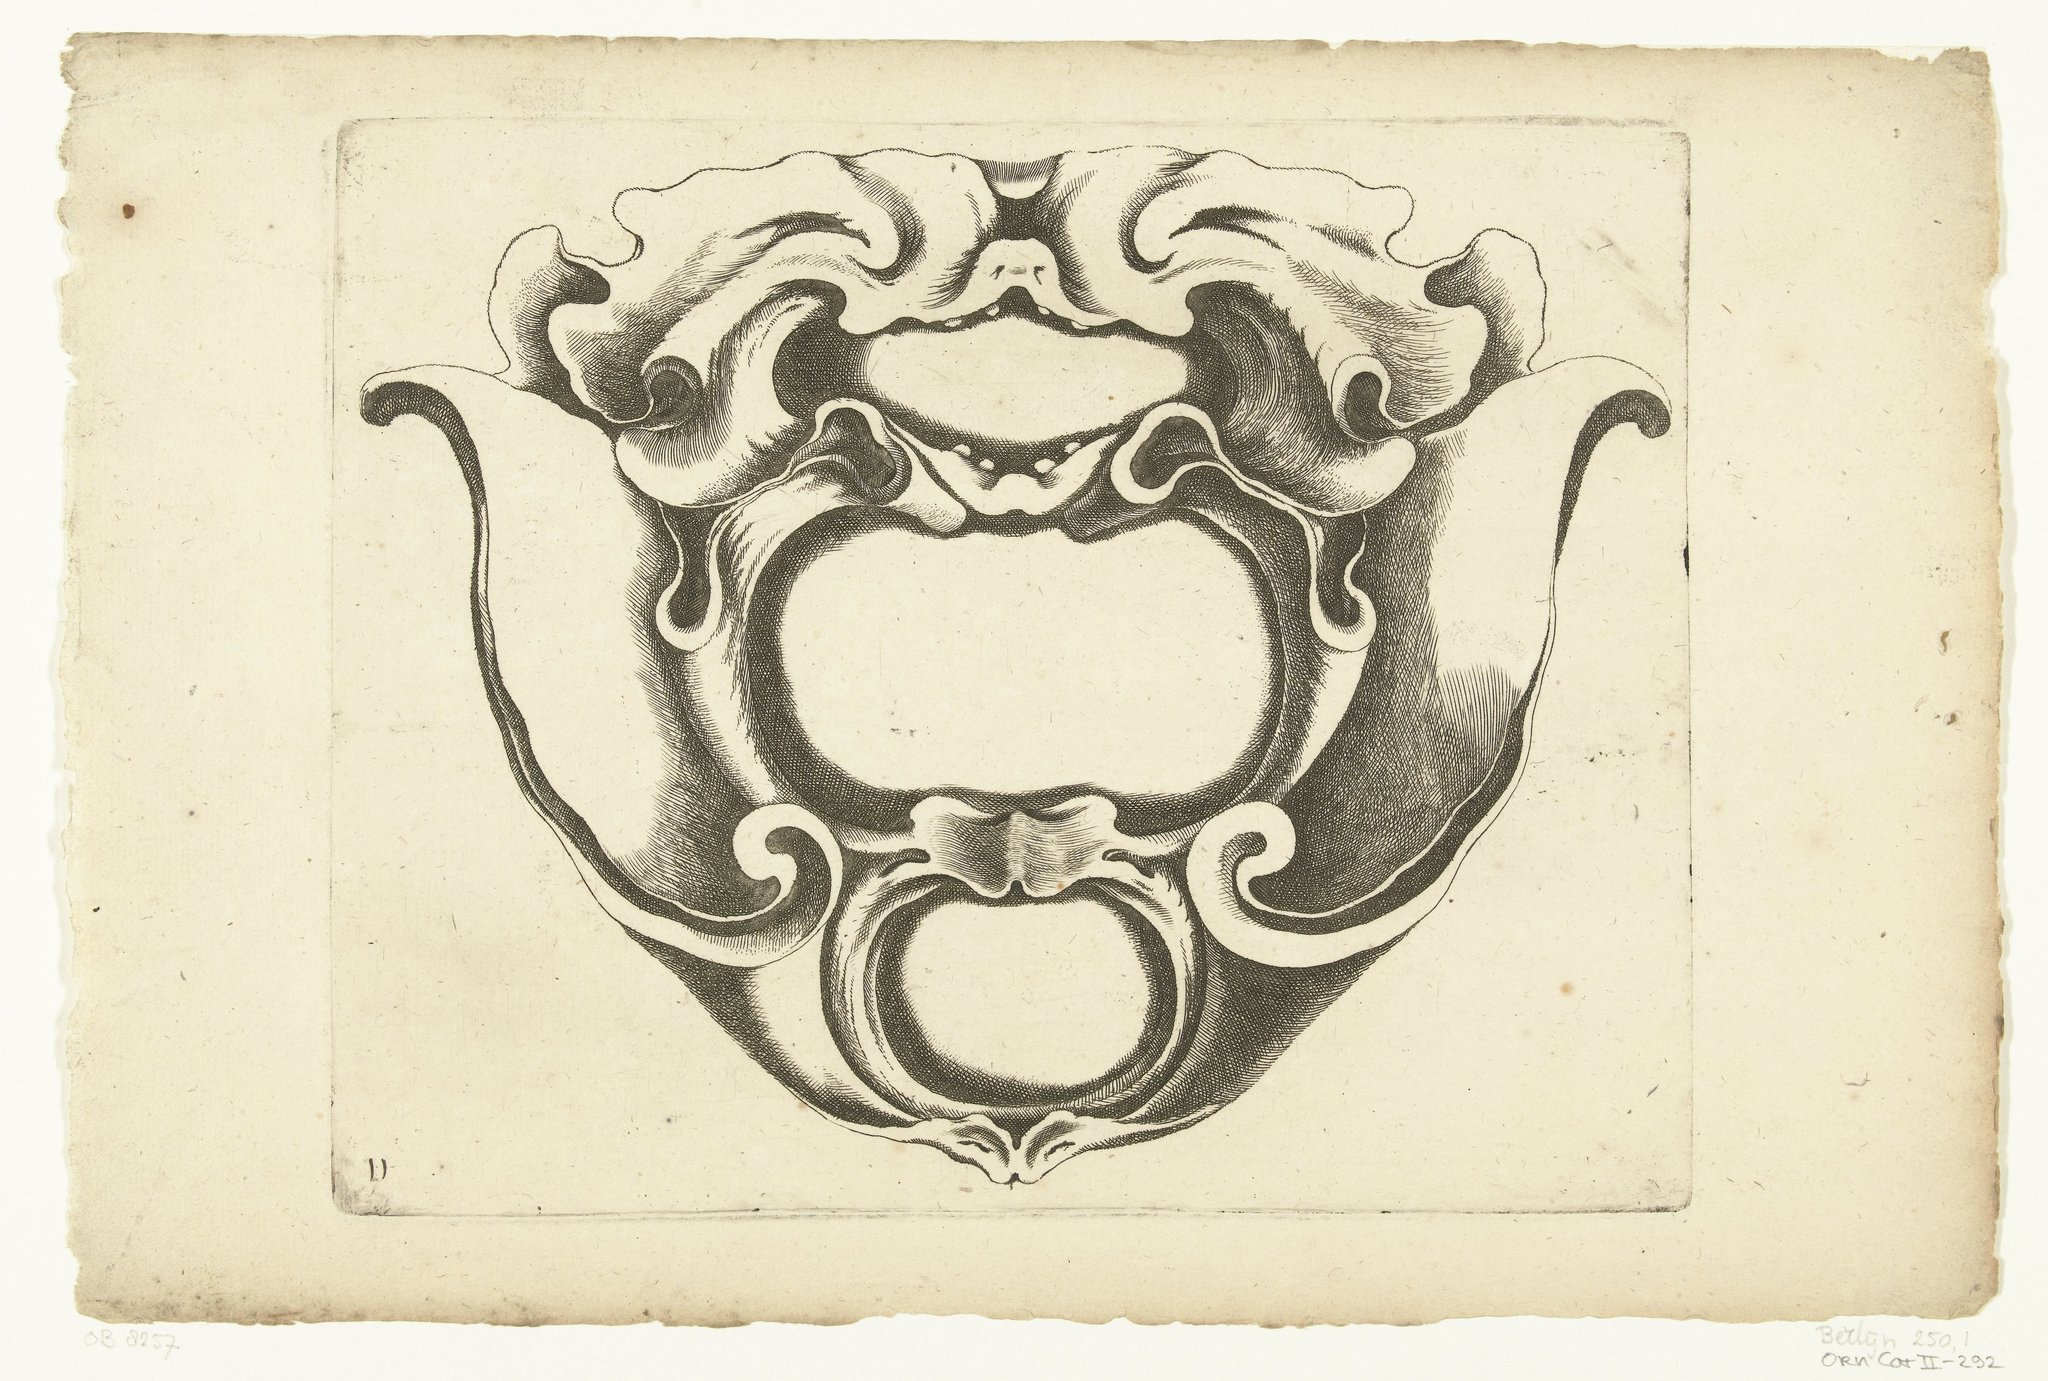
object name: ornament print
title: Veelderhande Nieuwe Compartemente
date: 1654-1678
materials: paper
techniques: etching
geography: amsterdam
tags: ornament ~ cartouche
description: Drie compartimenten onder elkaar. Bovenaan is het hoofd van een monster te zien.